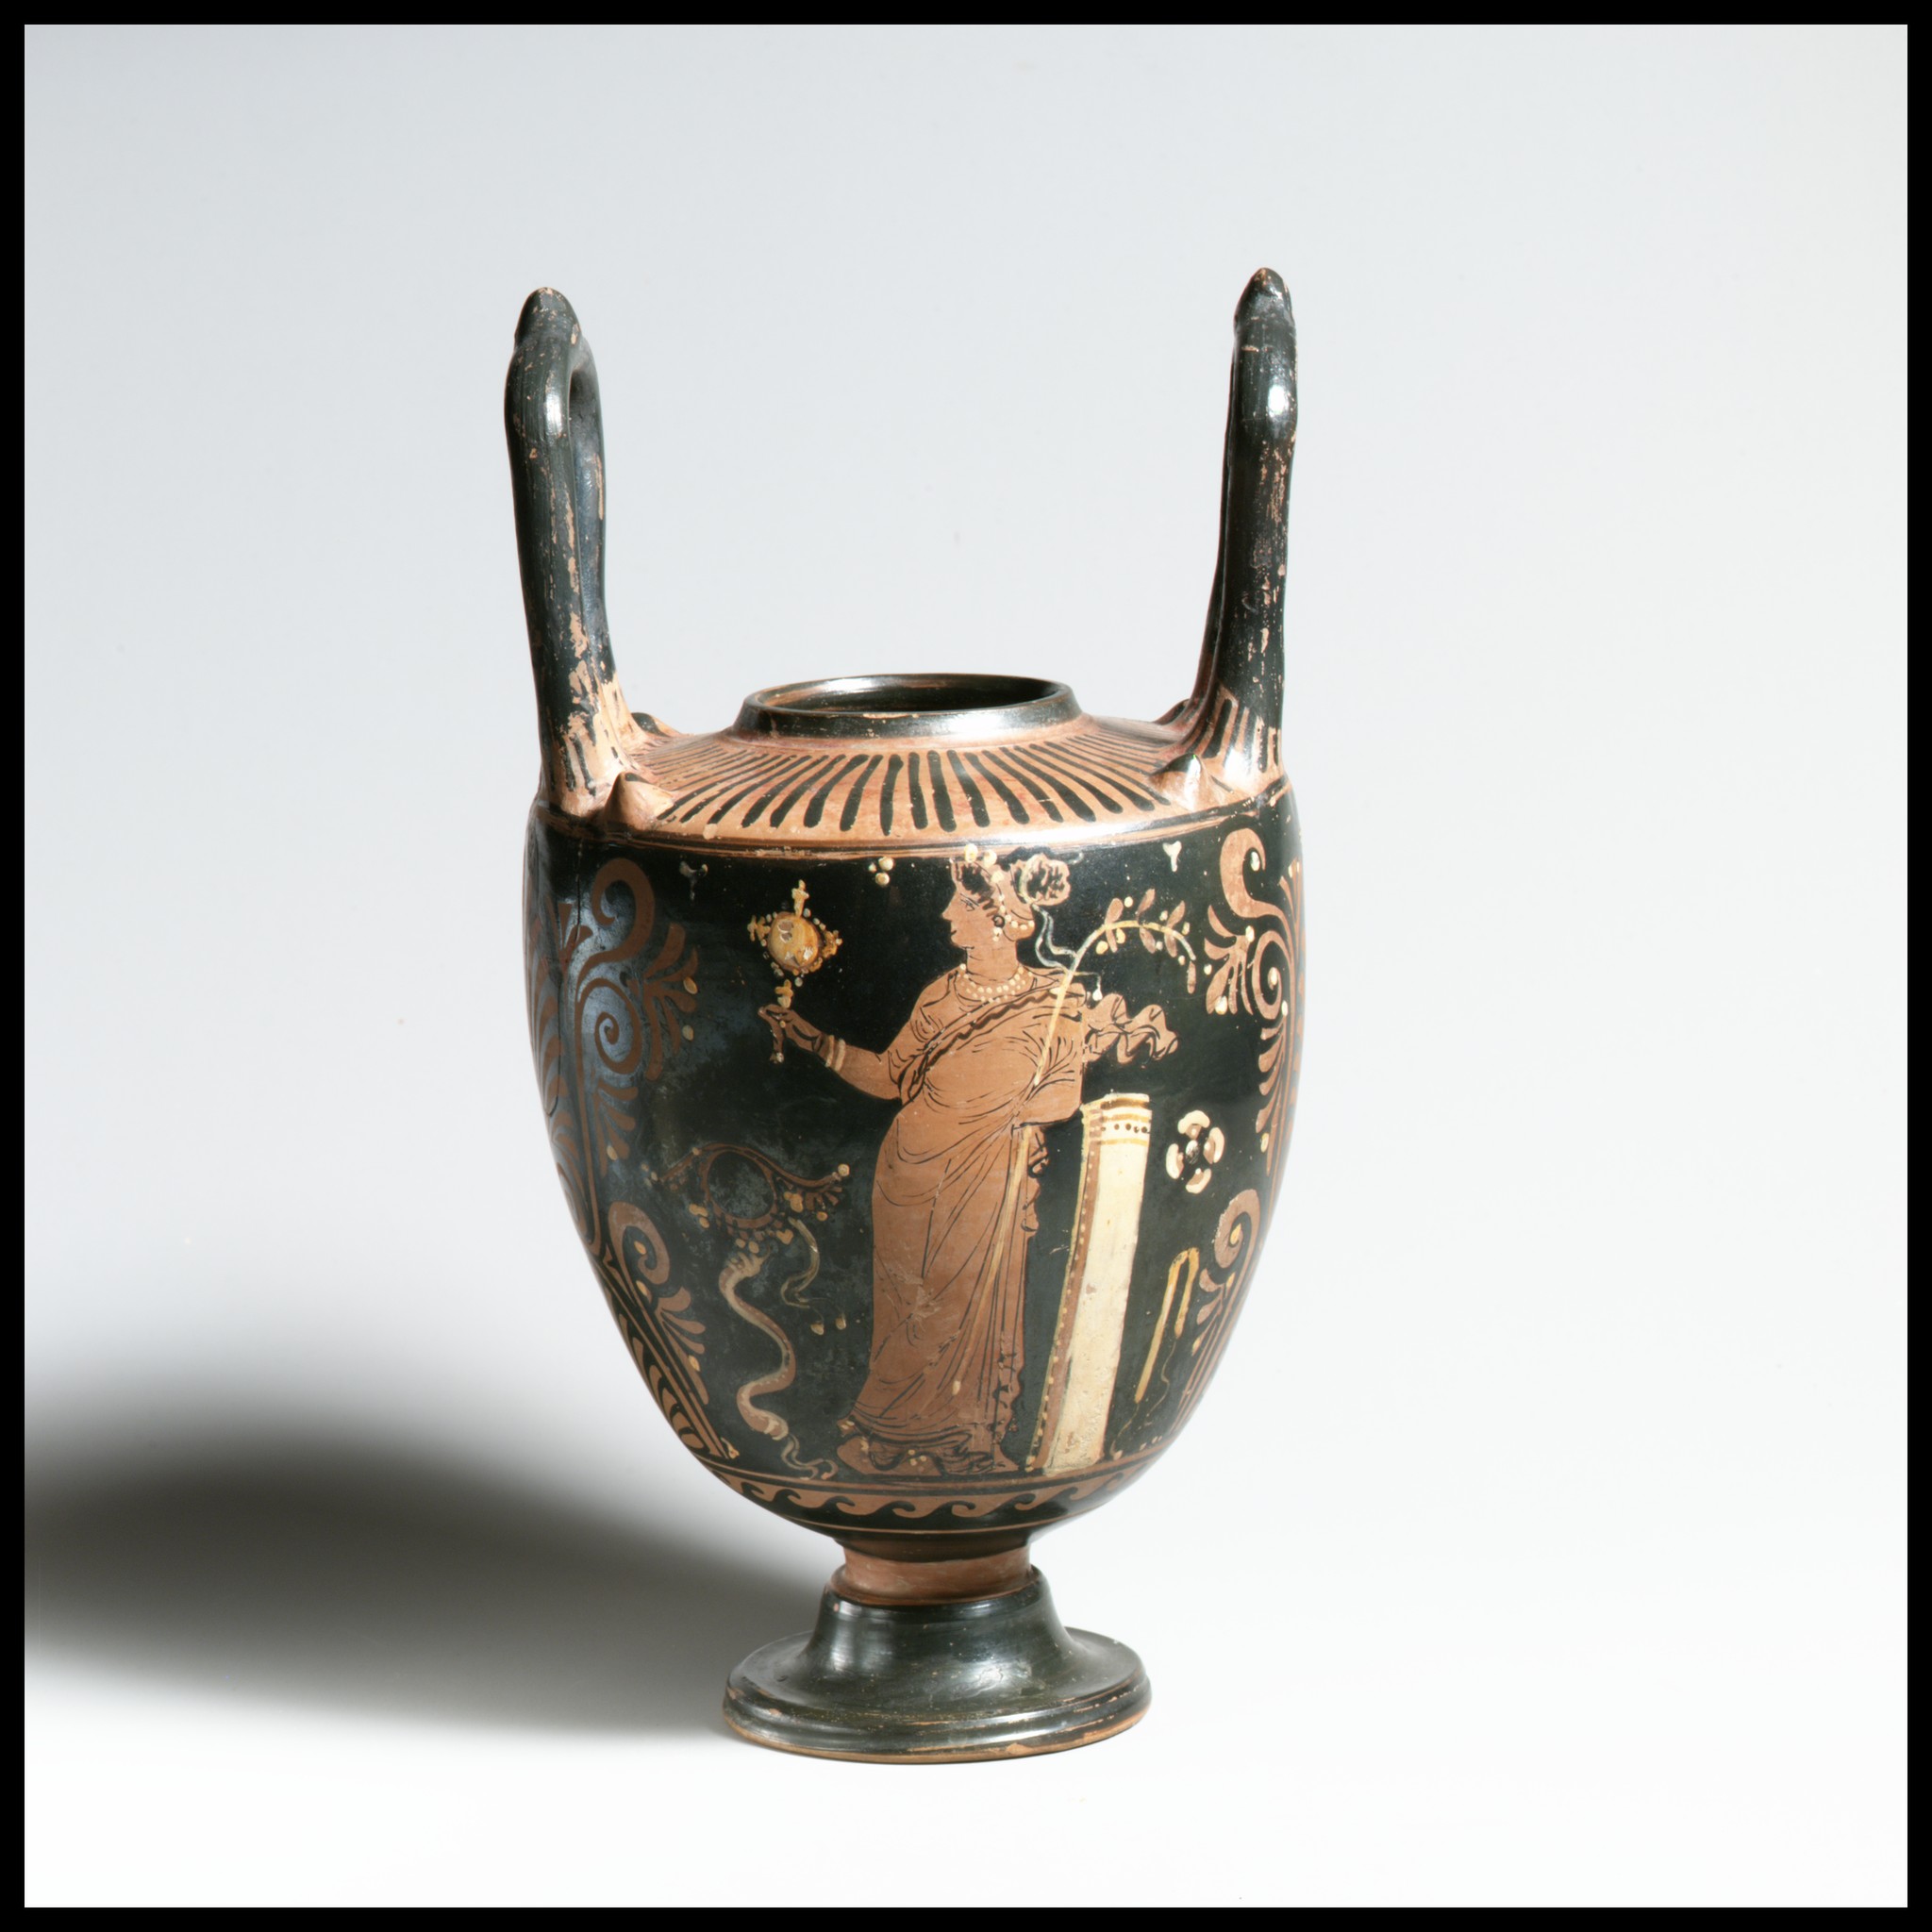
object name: lebes gamikos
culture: greek, south italian, apulian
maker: liverpool group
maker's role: artist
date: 340-320 BCE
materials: terracotta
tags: women,mirrors